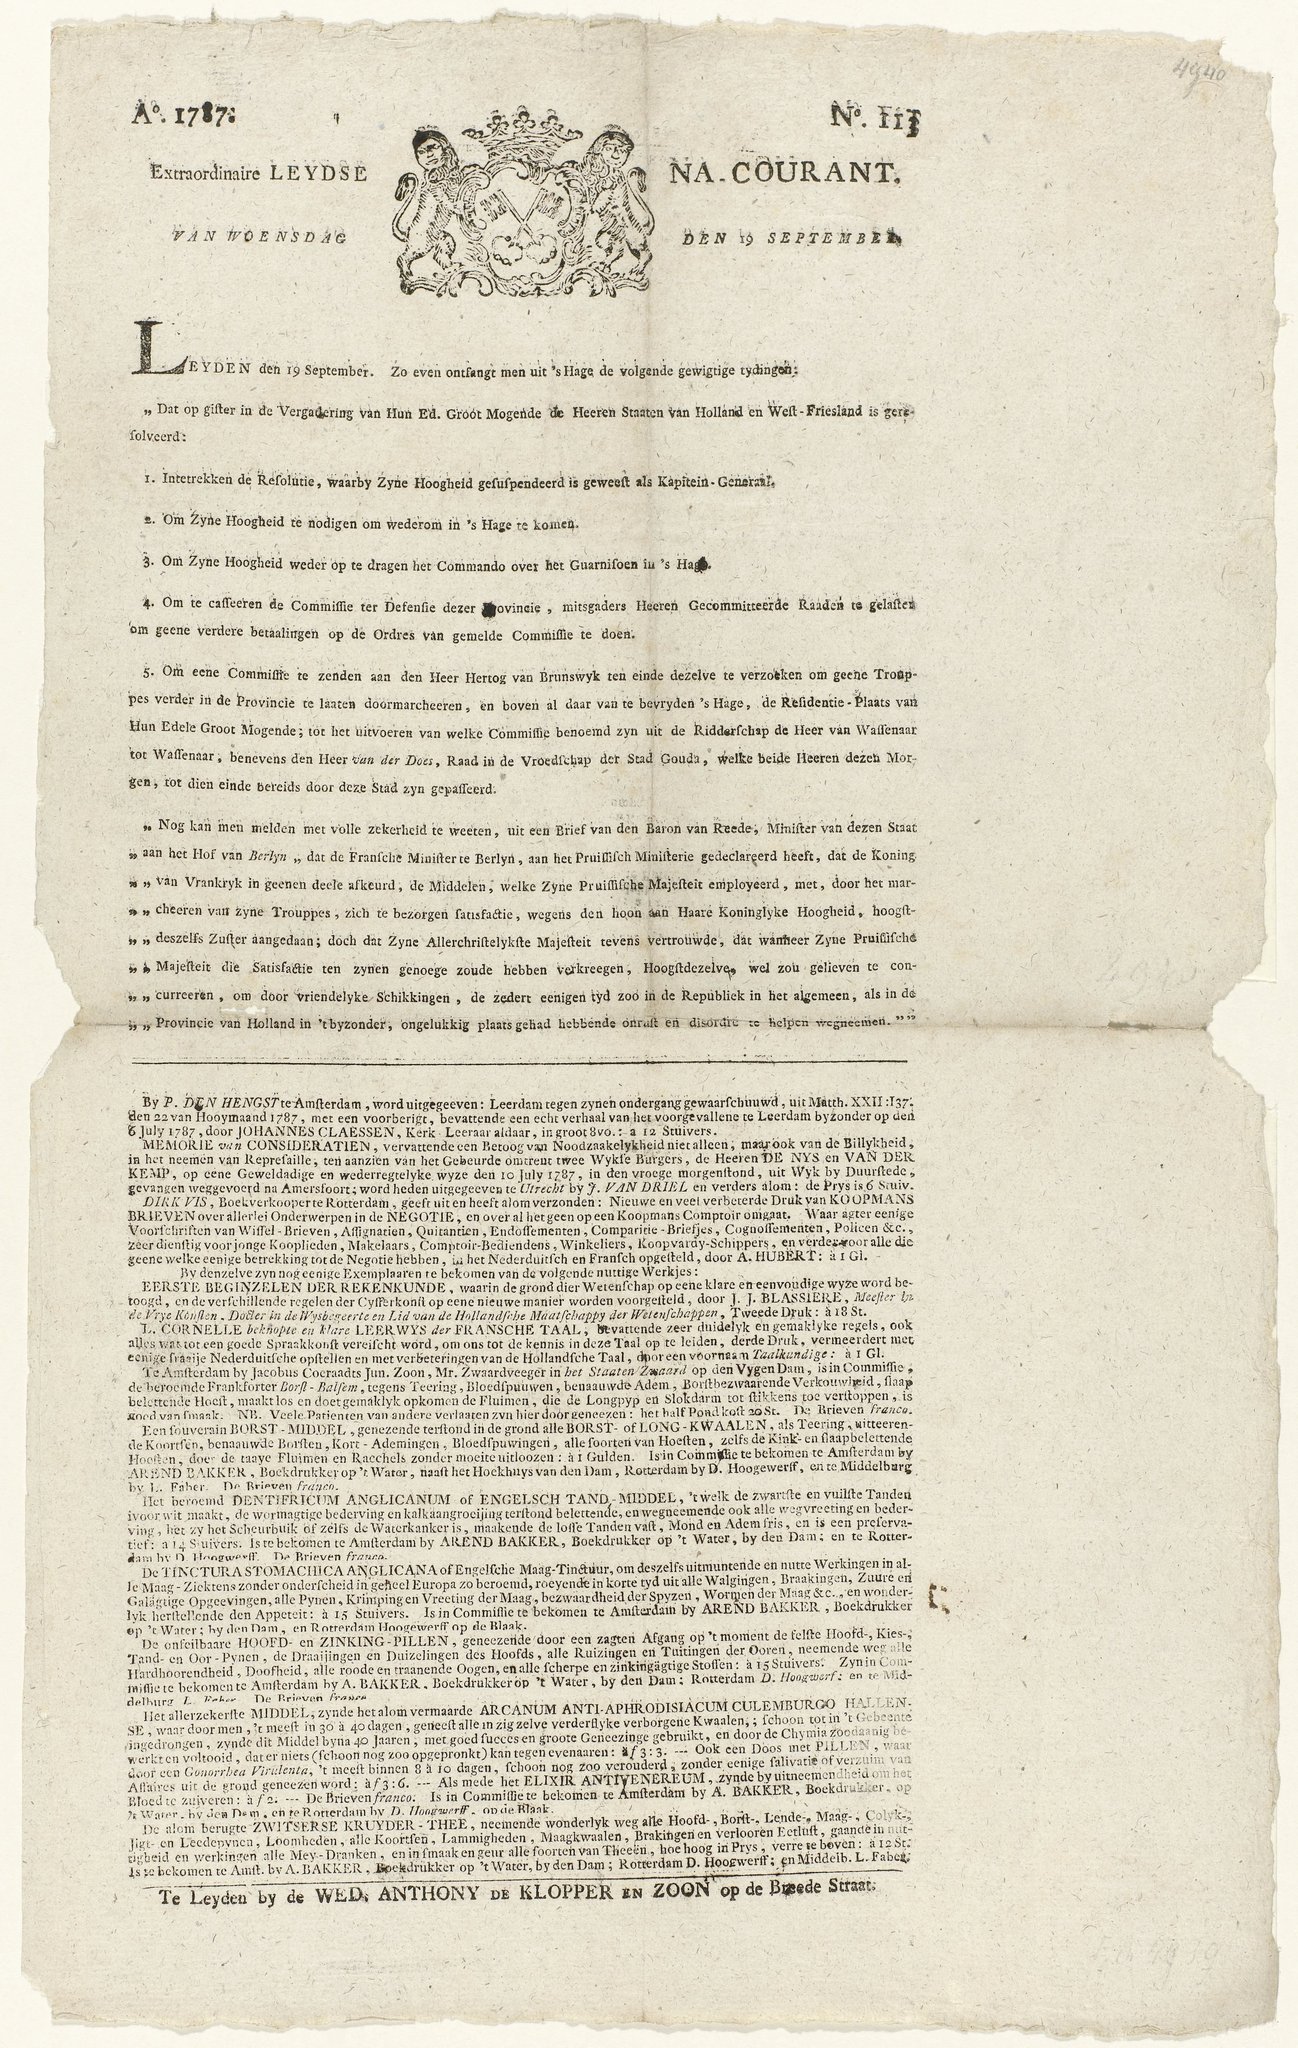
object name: newspaper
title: Aflevering van de Extraordinaire Leydse Na-Courant 19 september 1787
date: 1787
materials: paper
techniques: letterpress printing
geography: leiden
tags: the hague, william v (prince of orange), leiden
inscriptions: collector's mark: Lugt 2228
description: Aflevering van de krant de Extraordinaire Leydse Na-Courant, van 19 september 1787, nr. 113. Bovenaan het stadswapen van Leiden, daaronder het nieuws over het herstel van de stadhouder Willem V in Den Haag.